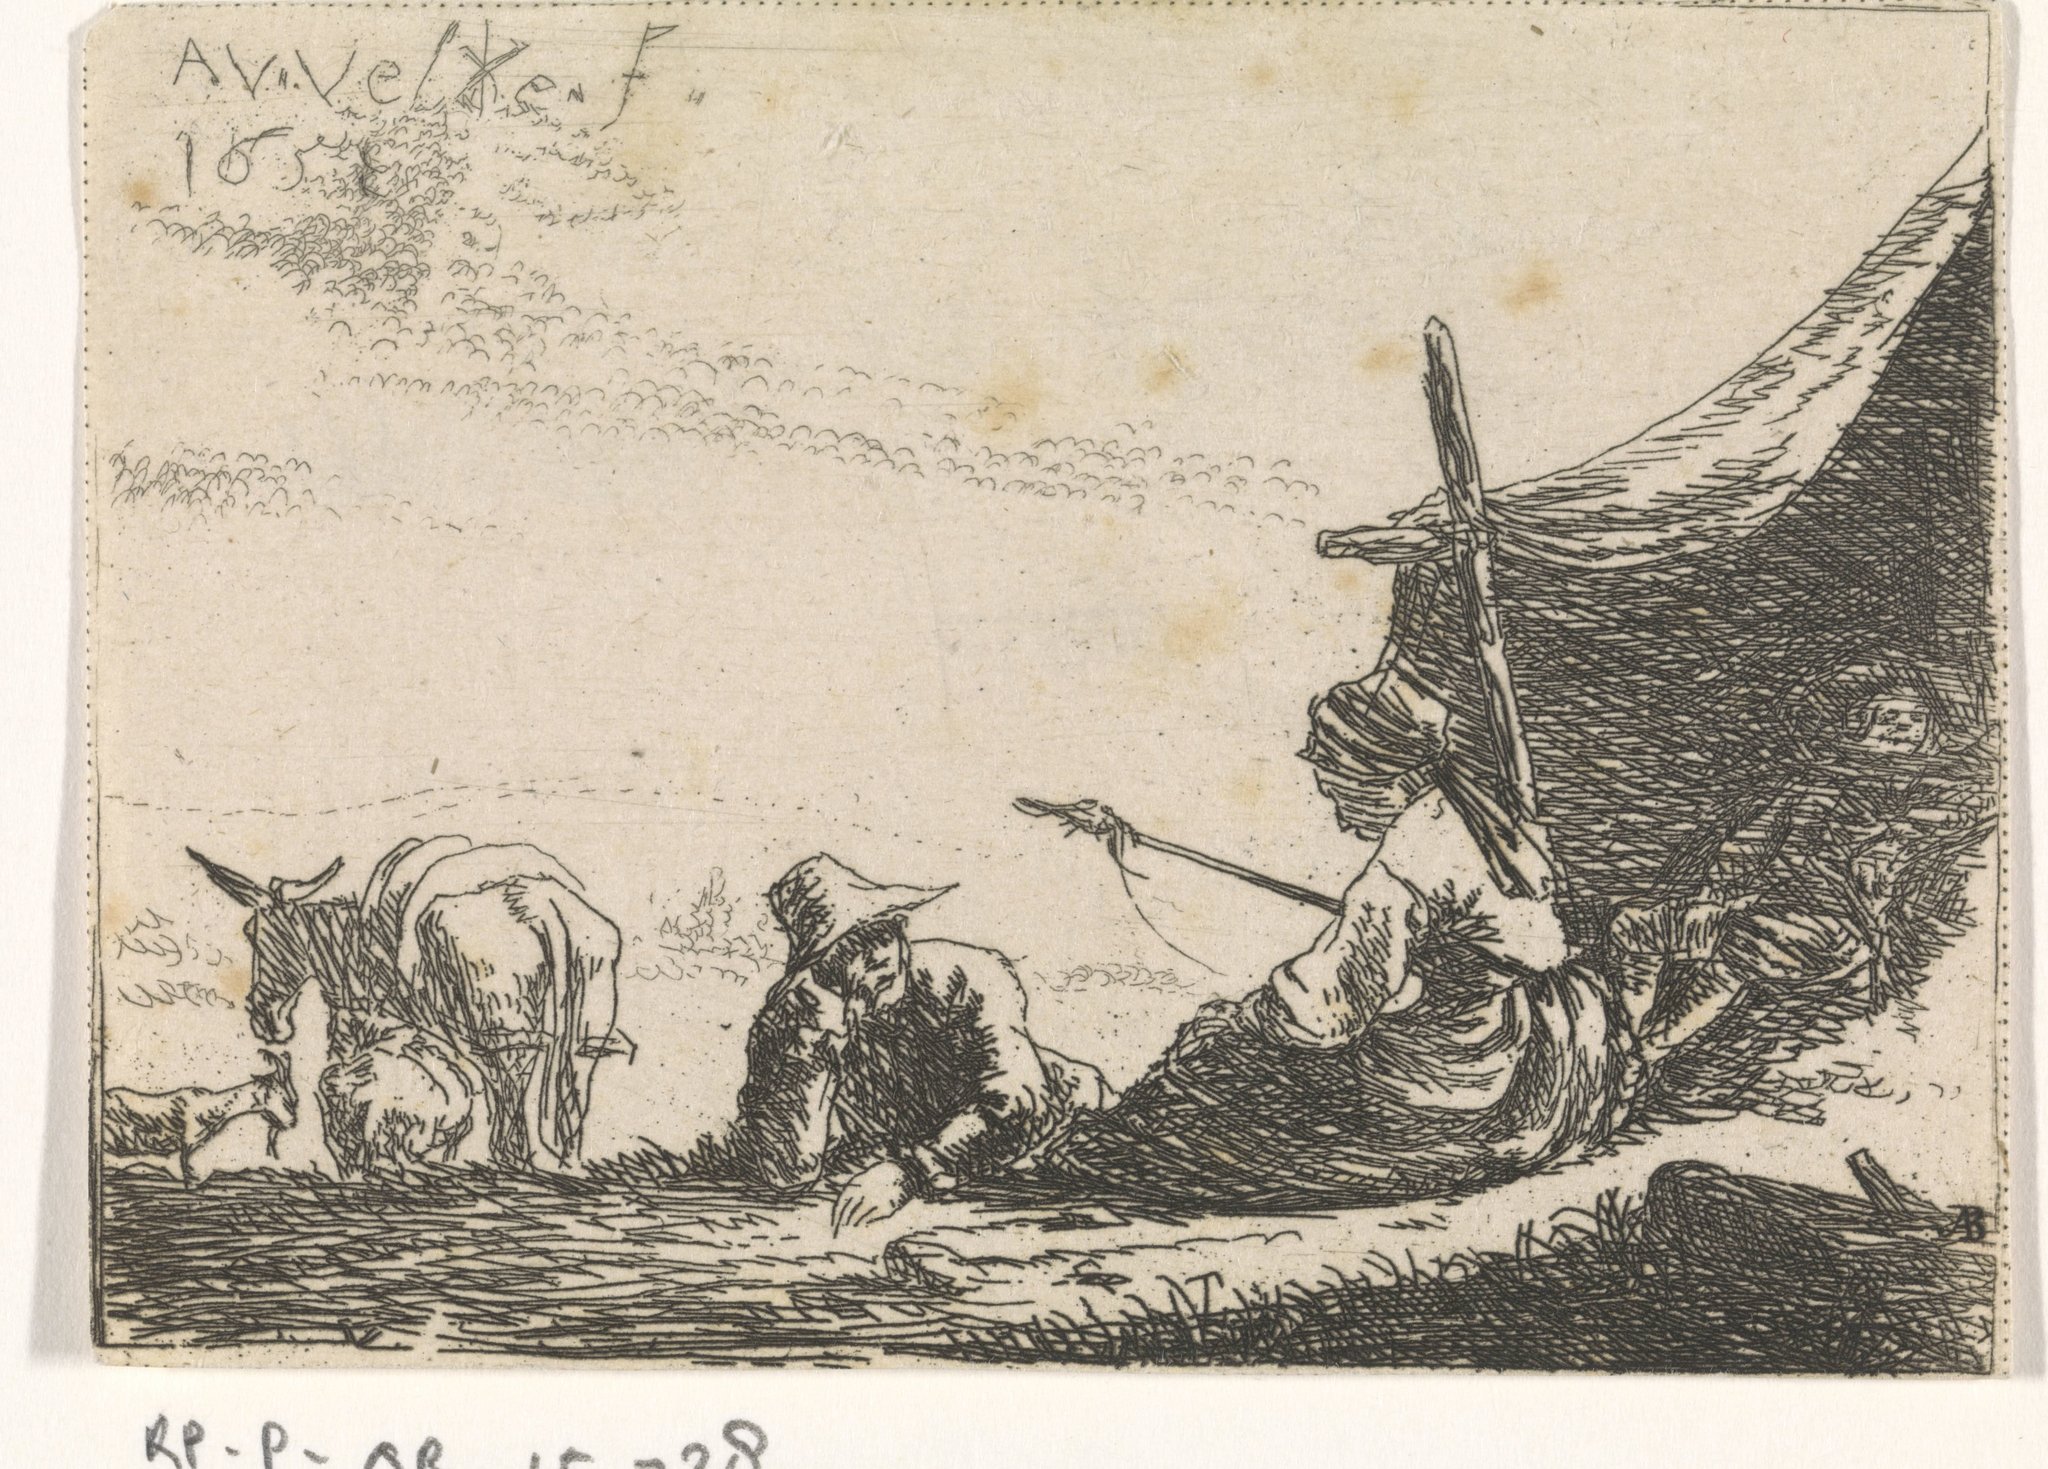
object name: print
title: Figuren bij een tent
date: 1653-1703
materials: paper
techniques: etching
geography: northern netherlands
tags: tent, ass, donkey, distaff, lying on one side, with uplifted upper part of the body and leaning on the arm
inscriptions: collector's mark: ‘F.G.W.’, collector's mark: Lugt 2228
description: Een zittende vrouw met een spinrok in de hand in gesprek met een liggende man, leunend op zijn elleboog, voor een tent. In de tent nog een derde figuur, links een ezel, een schaap en een geit.